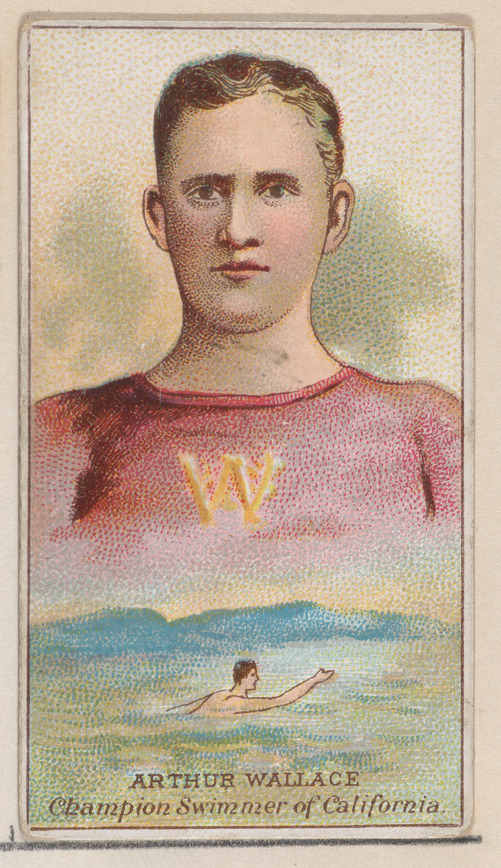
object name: print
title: Arthur Wallace, Champion Swimmer of California, from the Champions of Games and Sports series (N184, Type 2) issued by W.S. Kimball & Co.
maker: w.s. kimball & co.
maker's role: publisher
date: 1887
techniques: color lithograph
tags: men,swimming,athletes